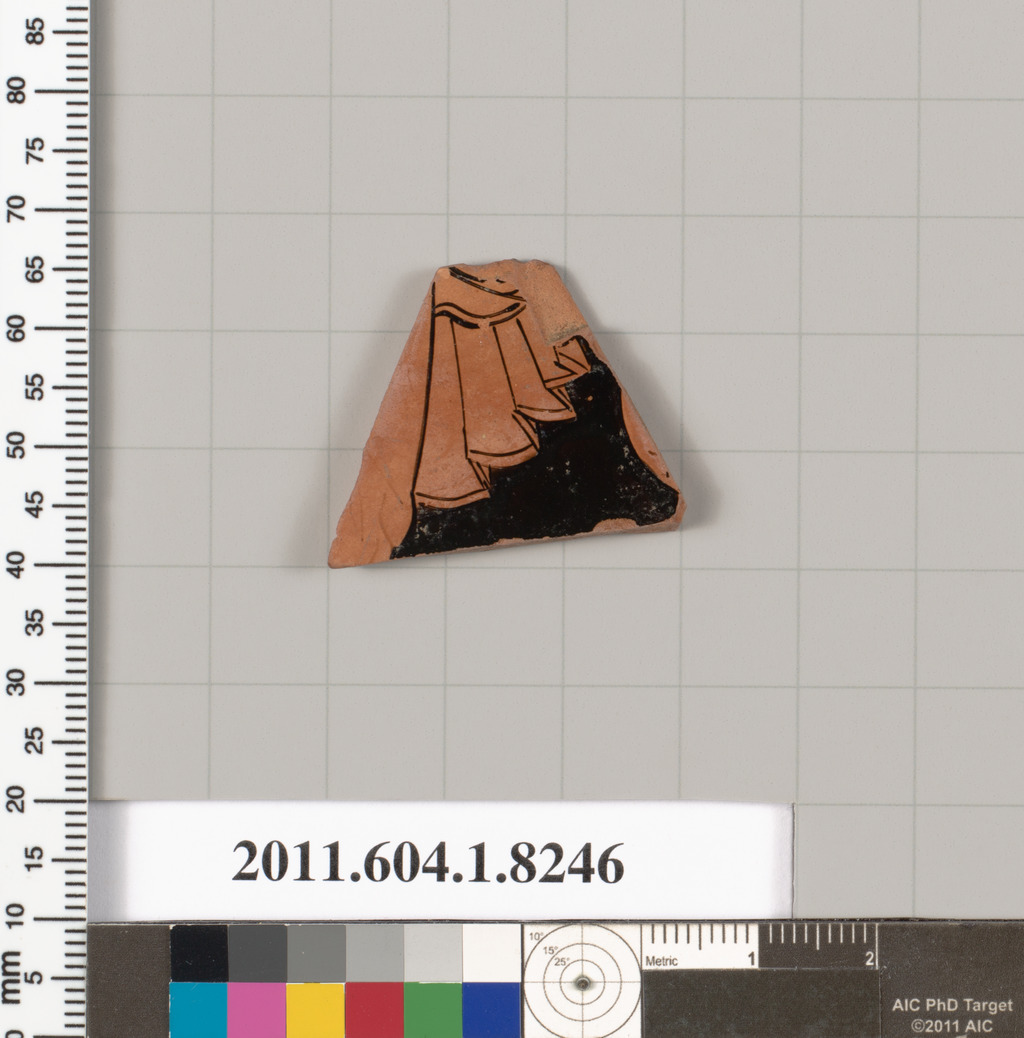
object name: kylix fragment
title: Terracotta fragment of a kylix (drinking cup)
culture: greek, attic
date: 520-510 BCE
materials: terracotta